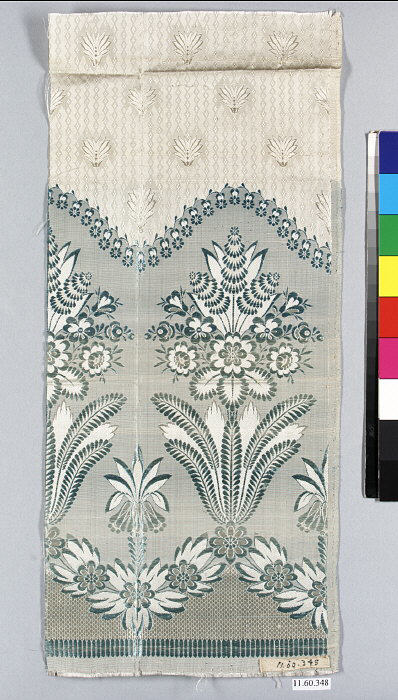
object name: fragment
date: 1801-1900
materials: silk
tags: flowers,leaves